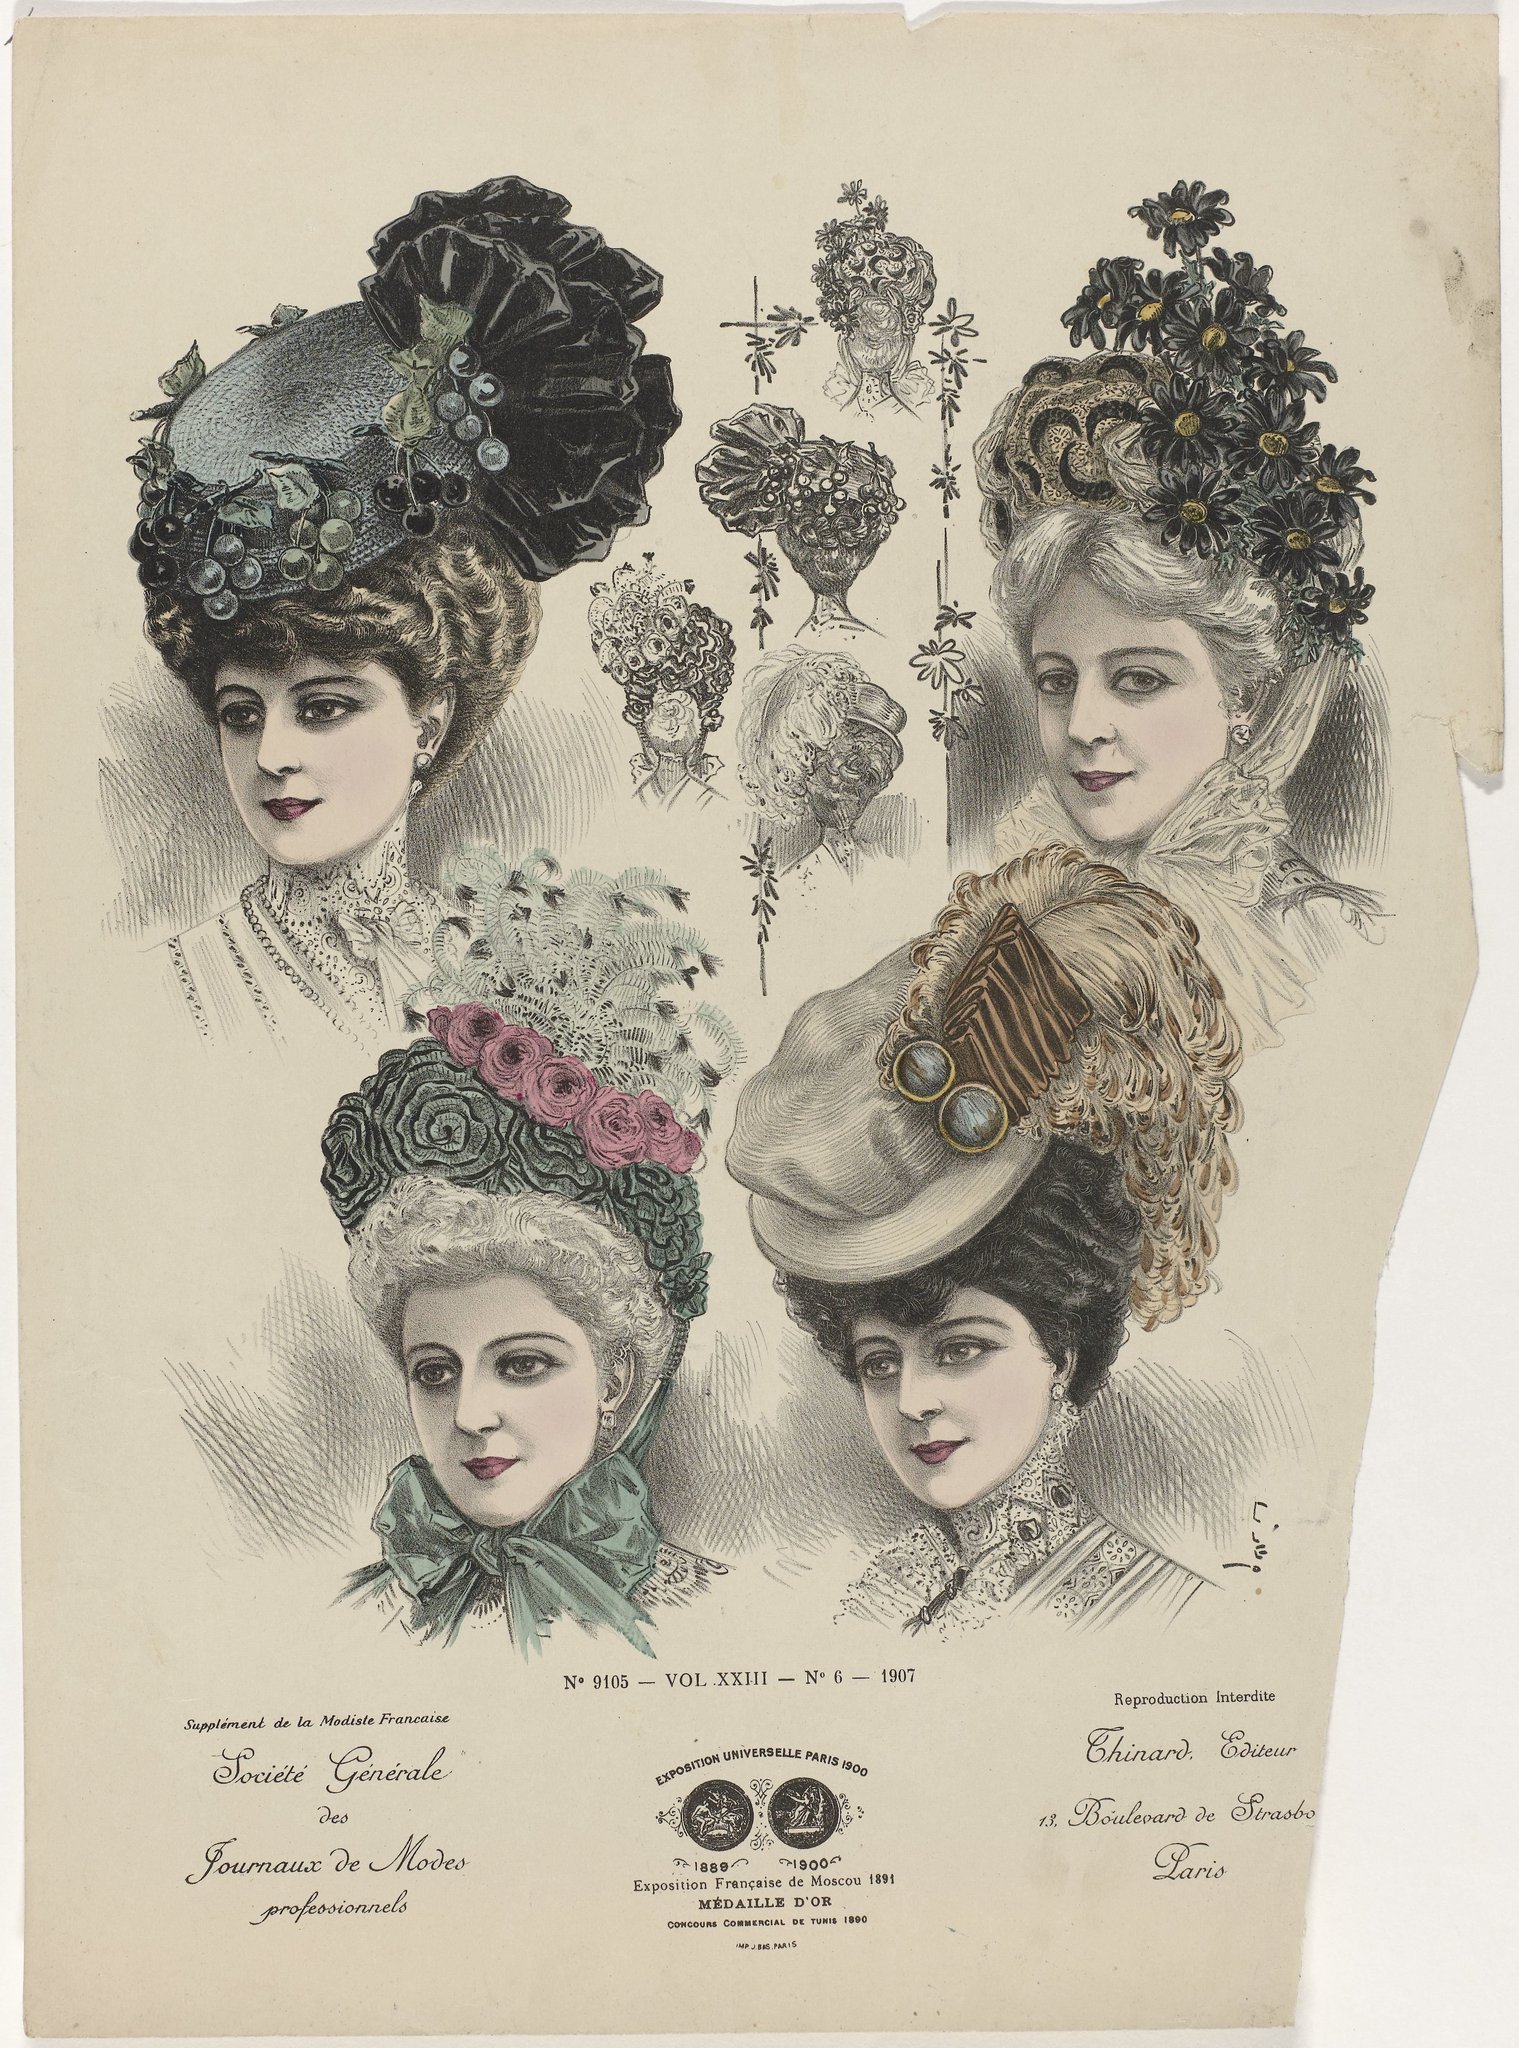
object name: fashion print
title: Supplément de la Modiste Française, Société Générale des Journaux de Modes professionnels 1907, No. 9105, Vol. XXIII, No. 6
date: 1907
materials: paper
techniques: hand coloring, lithograph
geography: paris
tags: flowers, fashion plates, head-gear: hat (+ women's clothes), fruits: cherry, head-gear: hat (+ feathers used for clothes)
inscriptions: title: ‘Supplément de la Modiste Francaise / Société Générale des Journaux de Modes professionels’, address: ‘Reproduction Interdite / Thinard Editeur 13, Boulevard de Strasbo Paris’, inscription: ‘EXPOSITION UNIVERSELLE PARIS 1900 / 1889 - 1900 / Exposition Française de Moscou 1891 / MÉDAILLE D'OR / CONCOURS COMMERCIAL DE TUNIS 1890’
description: Vier vrouwenhoofden met verschillende hoeden versierd met kersen, bloemen, veren en lint. Middenboven vier kleine lijntekeningen van de achterkant. Prent uit het modetijdschrift 'La Modiste Française' (1885-1914).